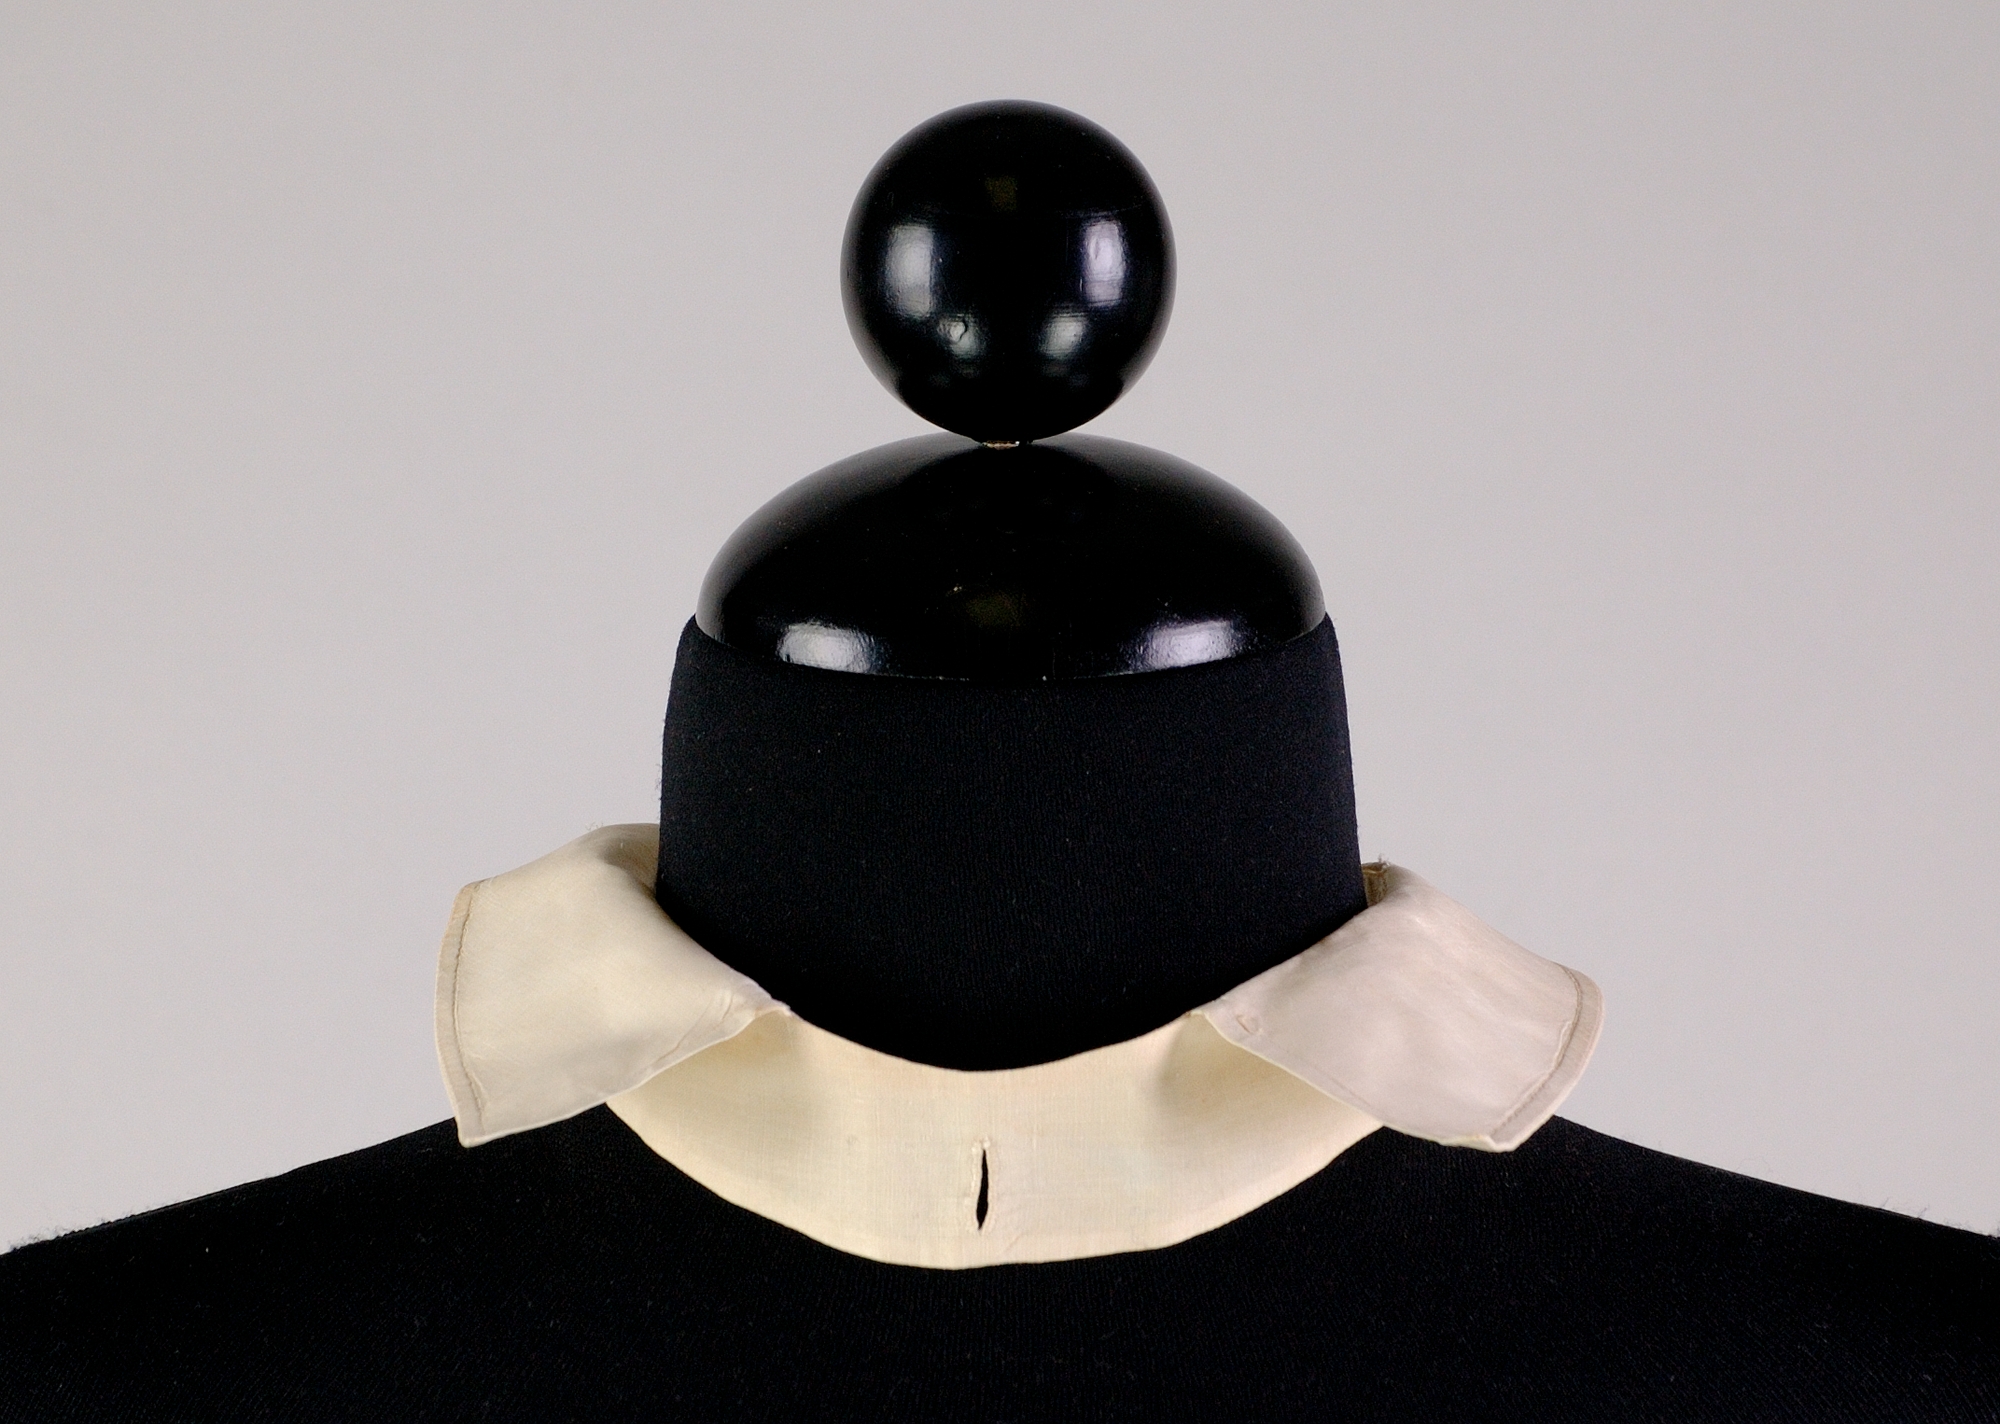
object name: collar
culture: american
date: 1850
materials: linen